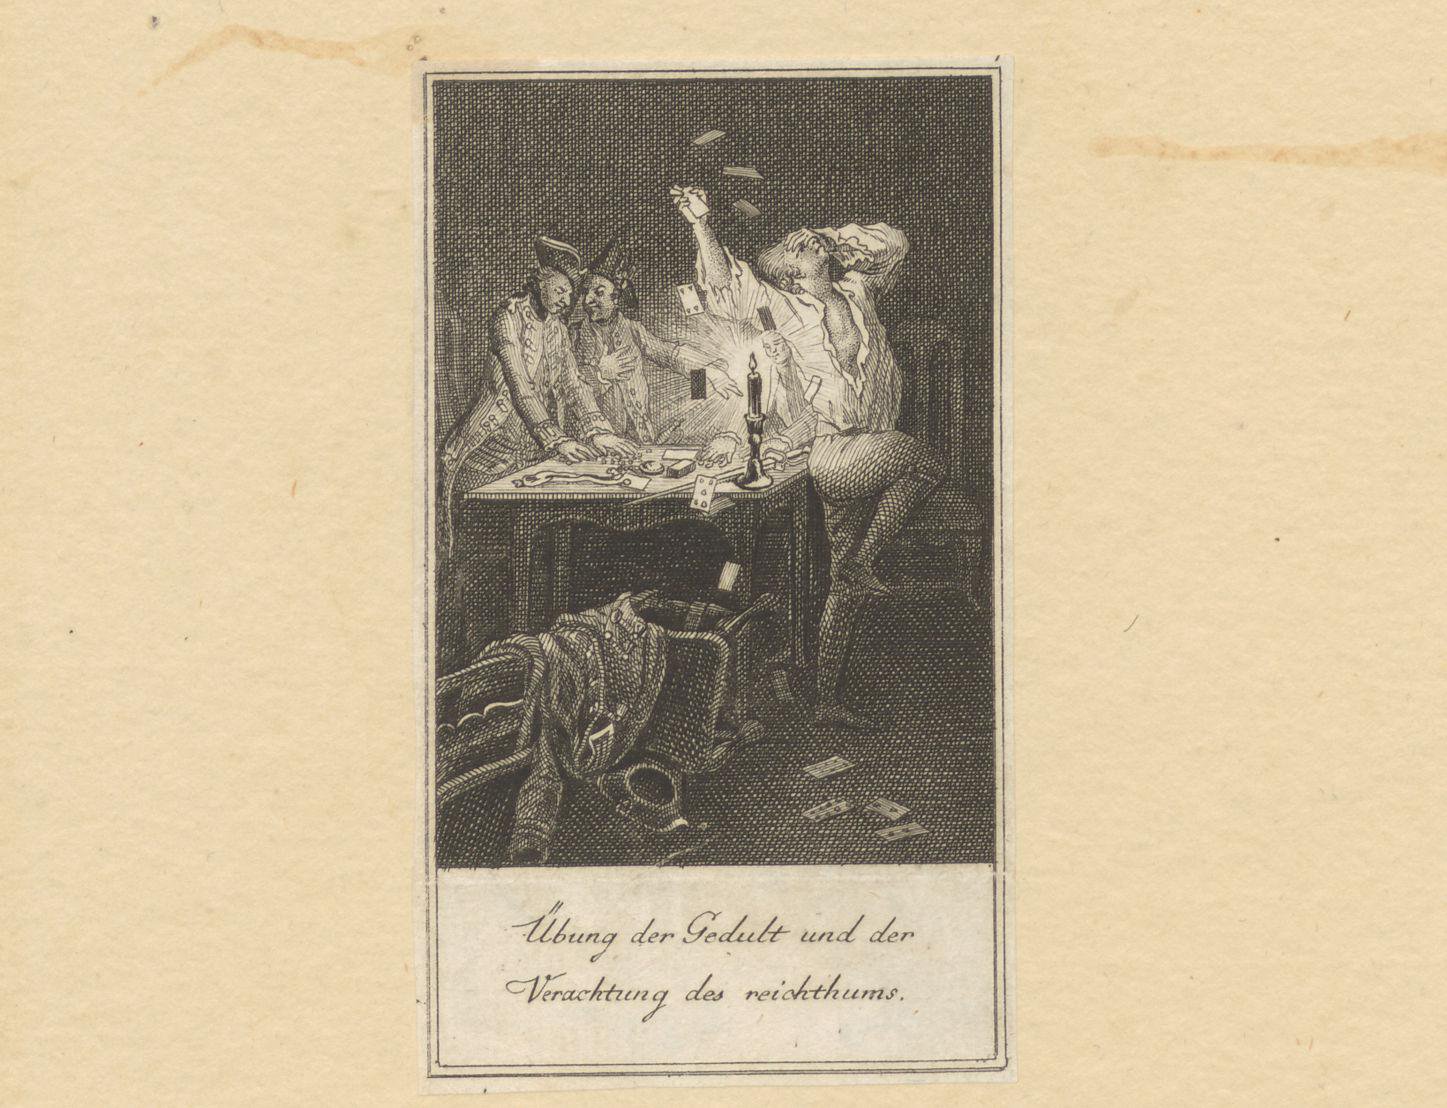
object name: print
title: Übung der Gedult und der Verachtung des Reichtums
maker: daniel berger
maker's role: print maker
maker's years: 1744-1824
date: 1773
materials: paper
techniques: etching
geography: berlin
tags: playing-cards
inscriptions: collector's mark: Lugt 2228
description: Prent afkomstig uit: Genealogischer Calender auf das Jahr 1774. Mit Genehmigung der Königlichen Academie der Wissenschaften zu Berlin herausgegeben. Zevende scène uit de serie 'Das Leben eines Lüderlichen', bestaand uit twaalf scènes, gedrukt van een koperplaat.